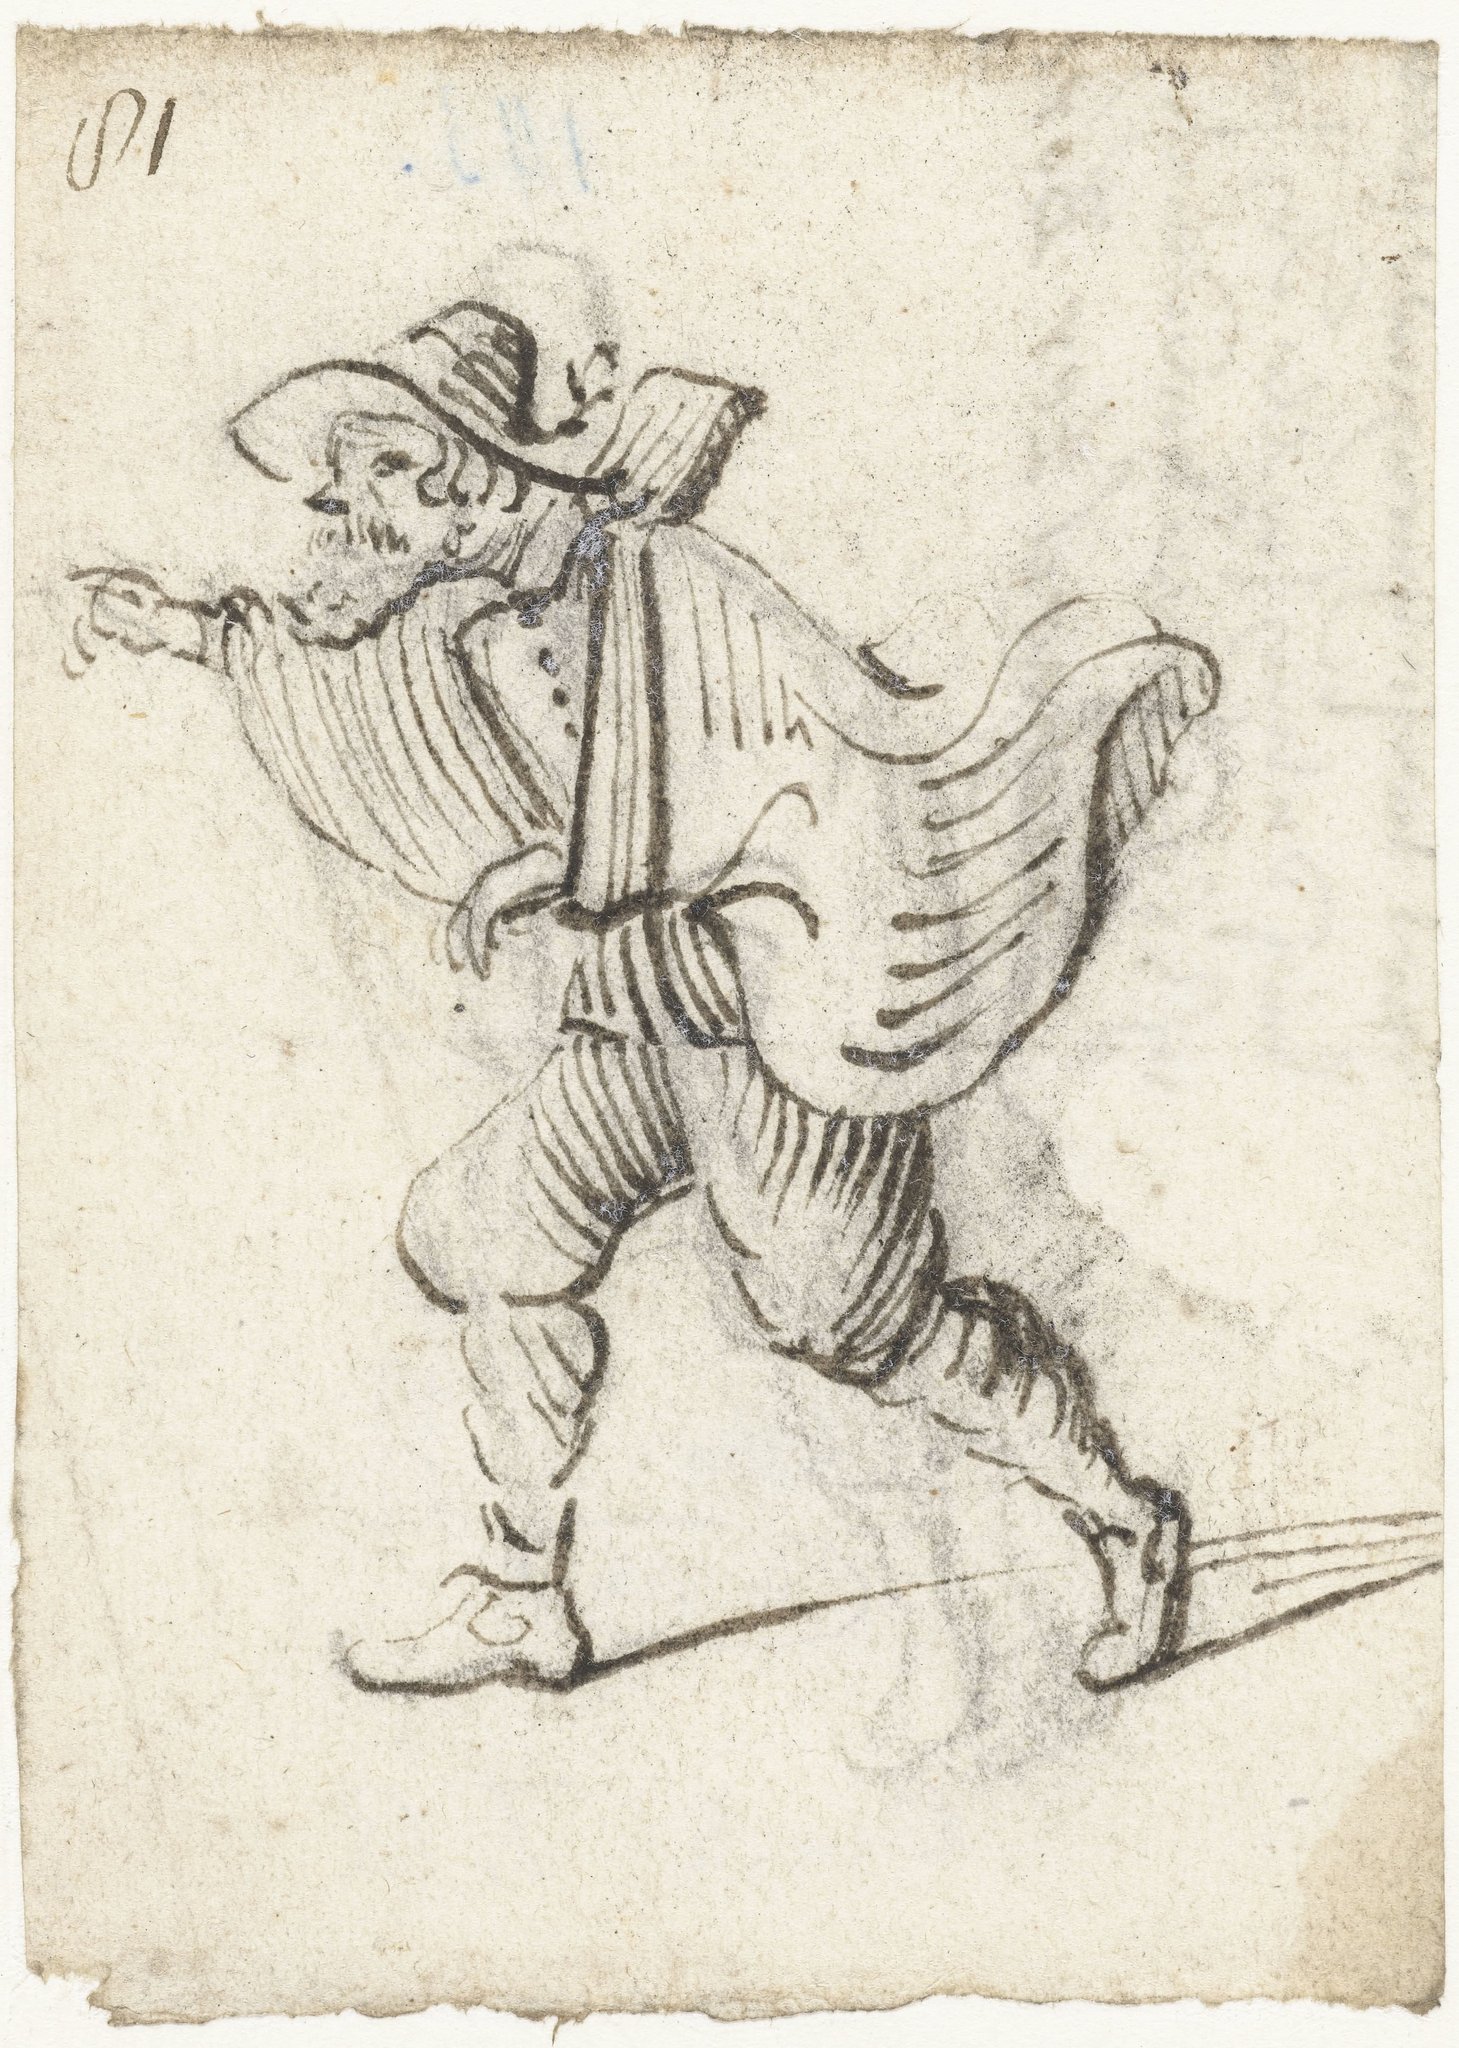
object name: drawing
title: Man met baard, naar links rennend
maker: harmen ter borch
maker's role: draughtsman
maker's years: 1638-1677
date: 1649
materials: chalk, paper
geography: zwolle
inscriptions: inscription: ‘Gerhard ter Borc[h]’, inscription, annotation: ‘Oude T.B.’